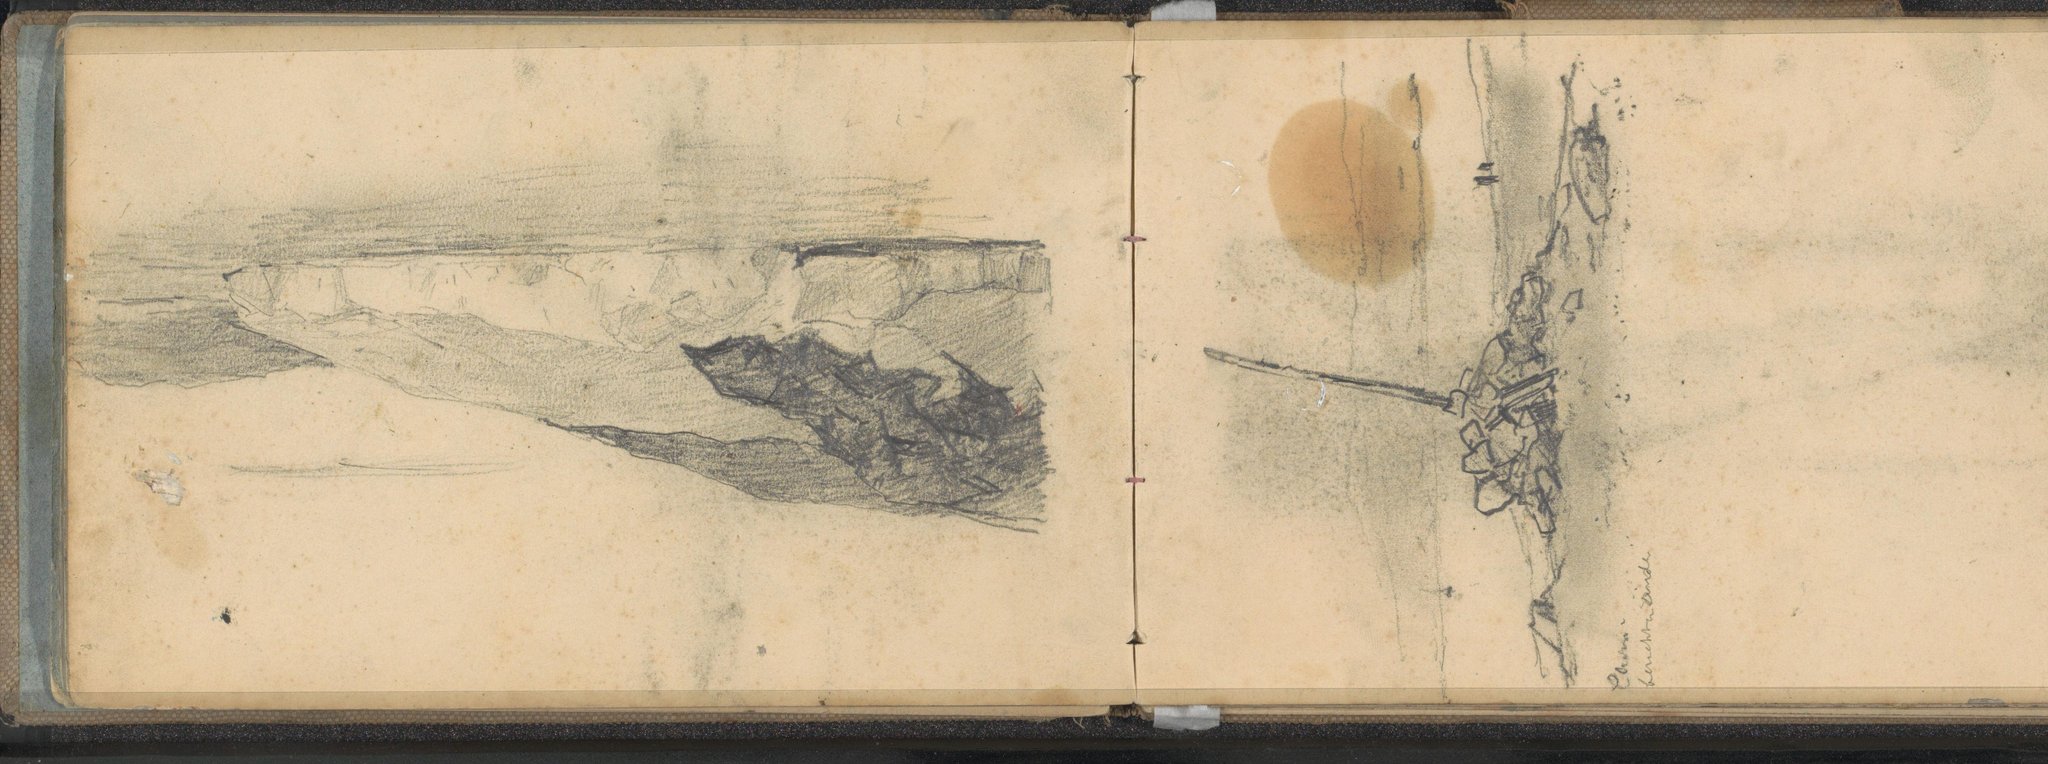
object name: sketchbook leaf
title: Gezicht op een cairn te Nova Zembla, mogelijk in de Kruisbaai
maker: louis apol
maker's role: draughtsman, painter, print maker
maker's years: 1850-1936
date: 1880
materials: paper, pencil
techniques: stumping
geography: novaya zemlya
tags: coast (in polar regions), boulder, stone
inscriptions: annotation: ‘Cairn/ berichten zenden’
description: Een cairn is een hoop stenen waaronder berichten werden achtergelaten. Blad 16 recto uit een schetsboek met 35 bladen betekend tijdens de expeditie naar Nova Zembla in 1880.